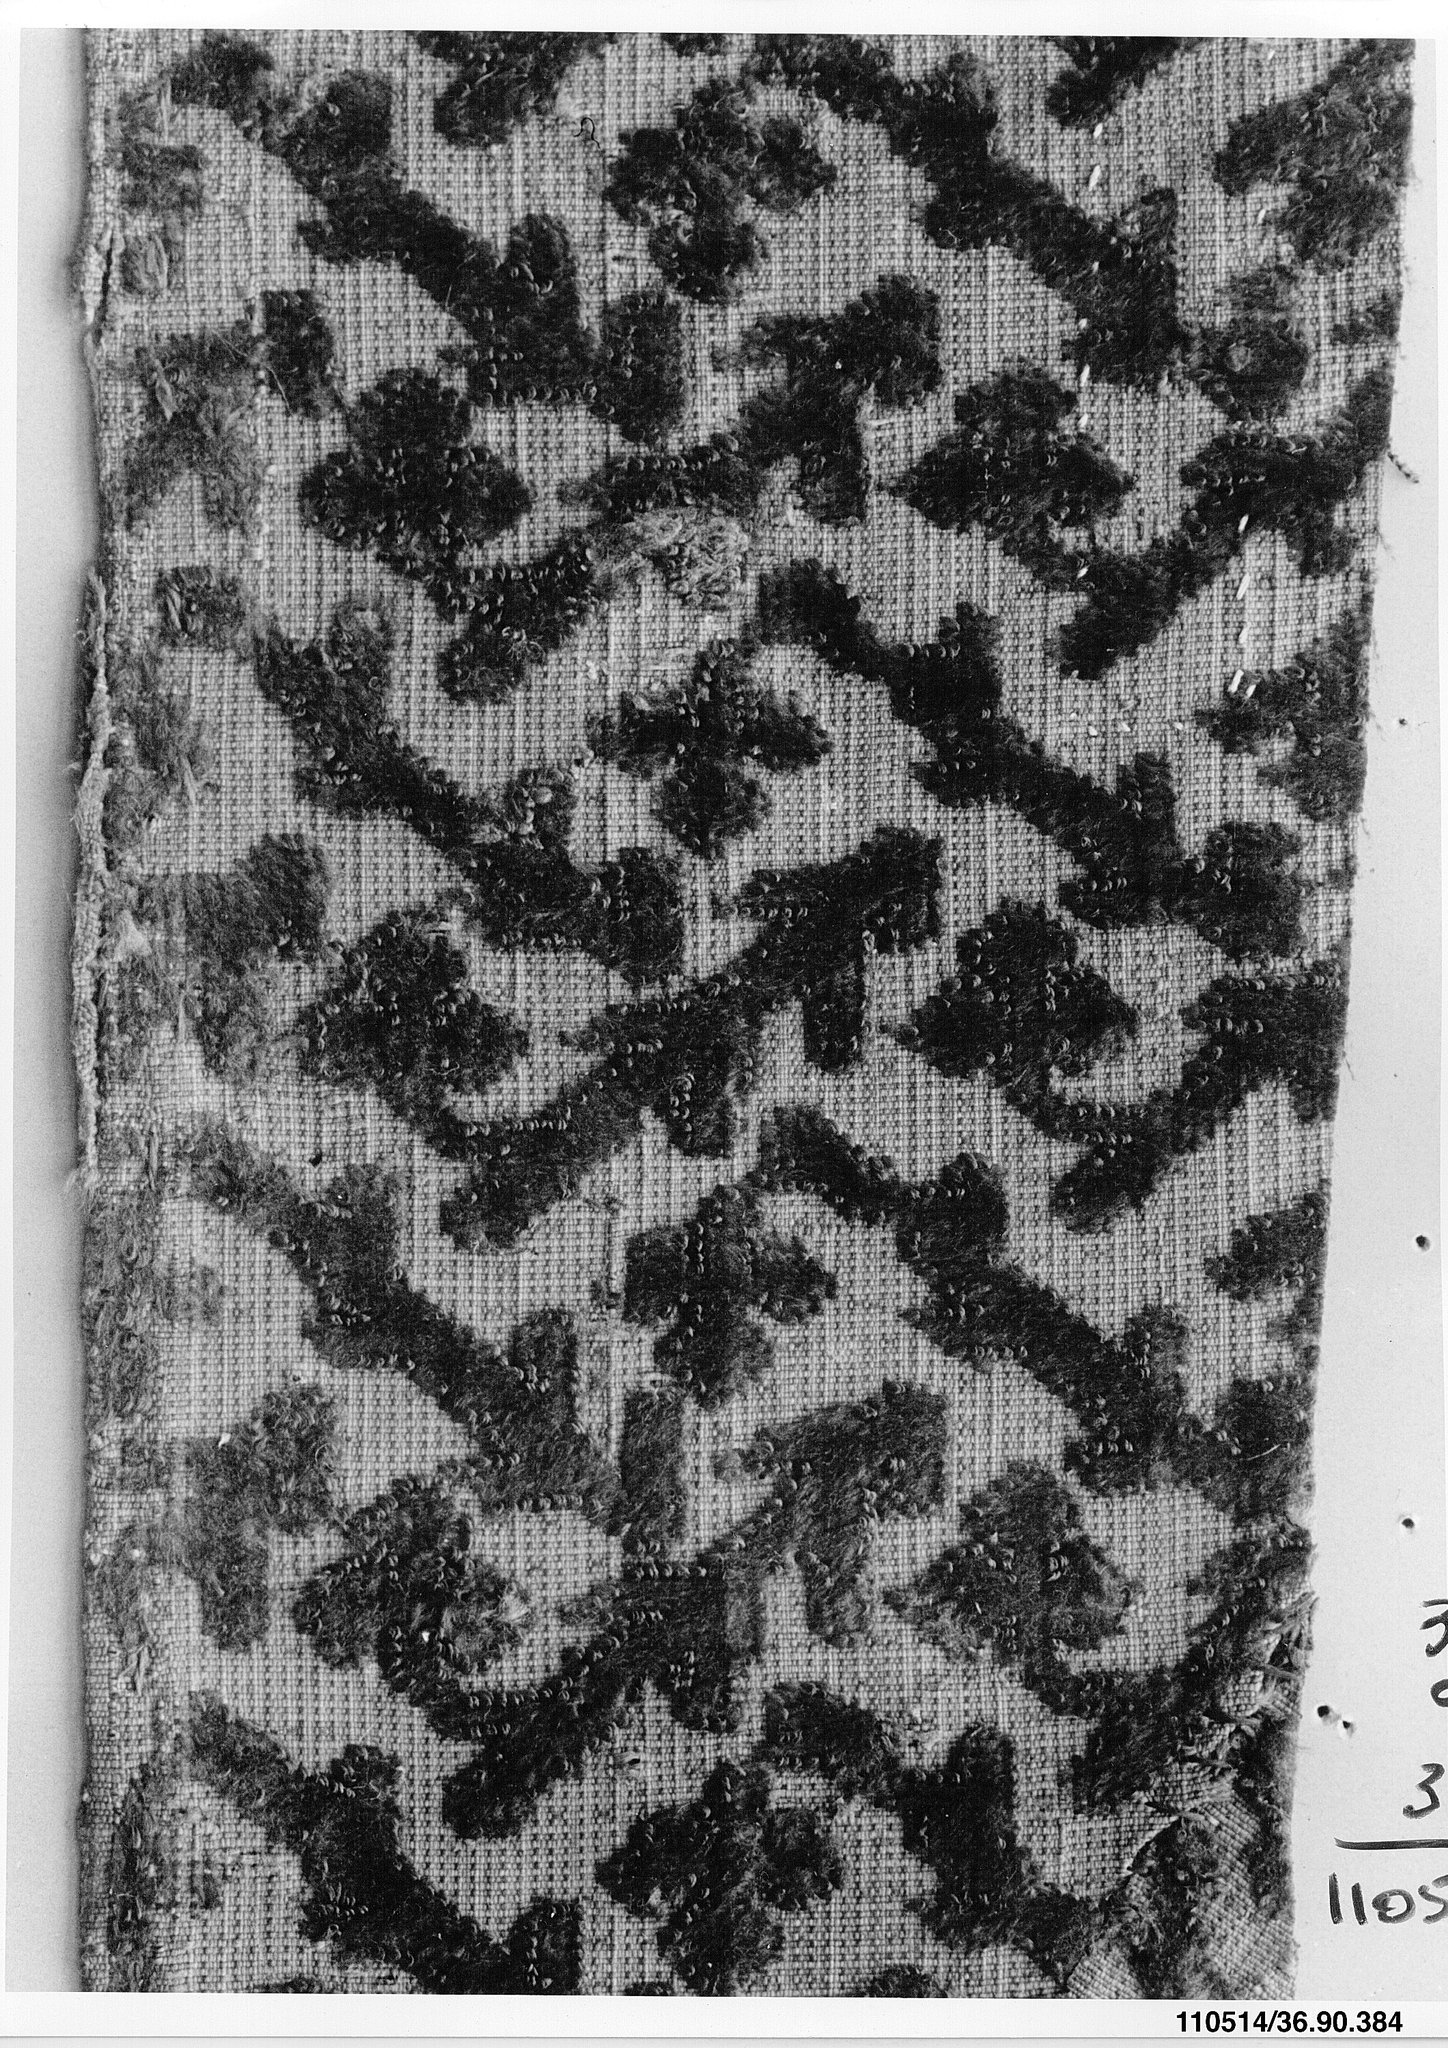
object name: piece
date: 1501-1700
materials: metal thread, silk